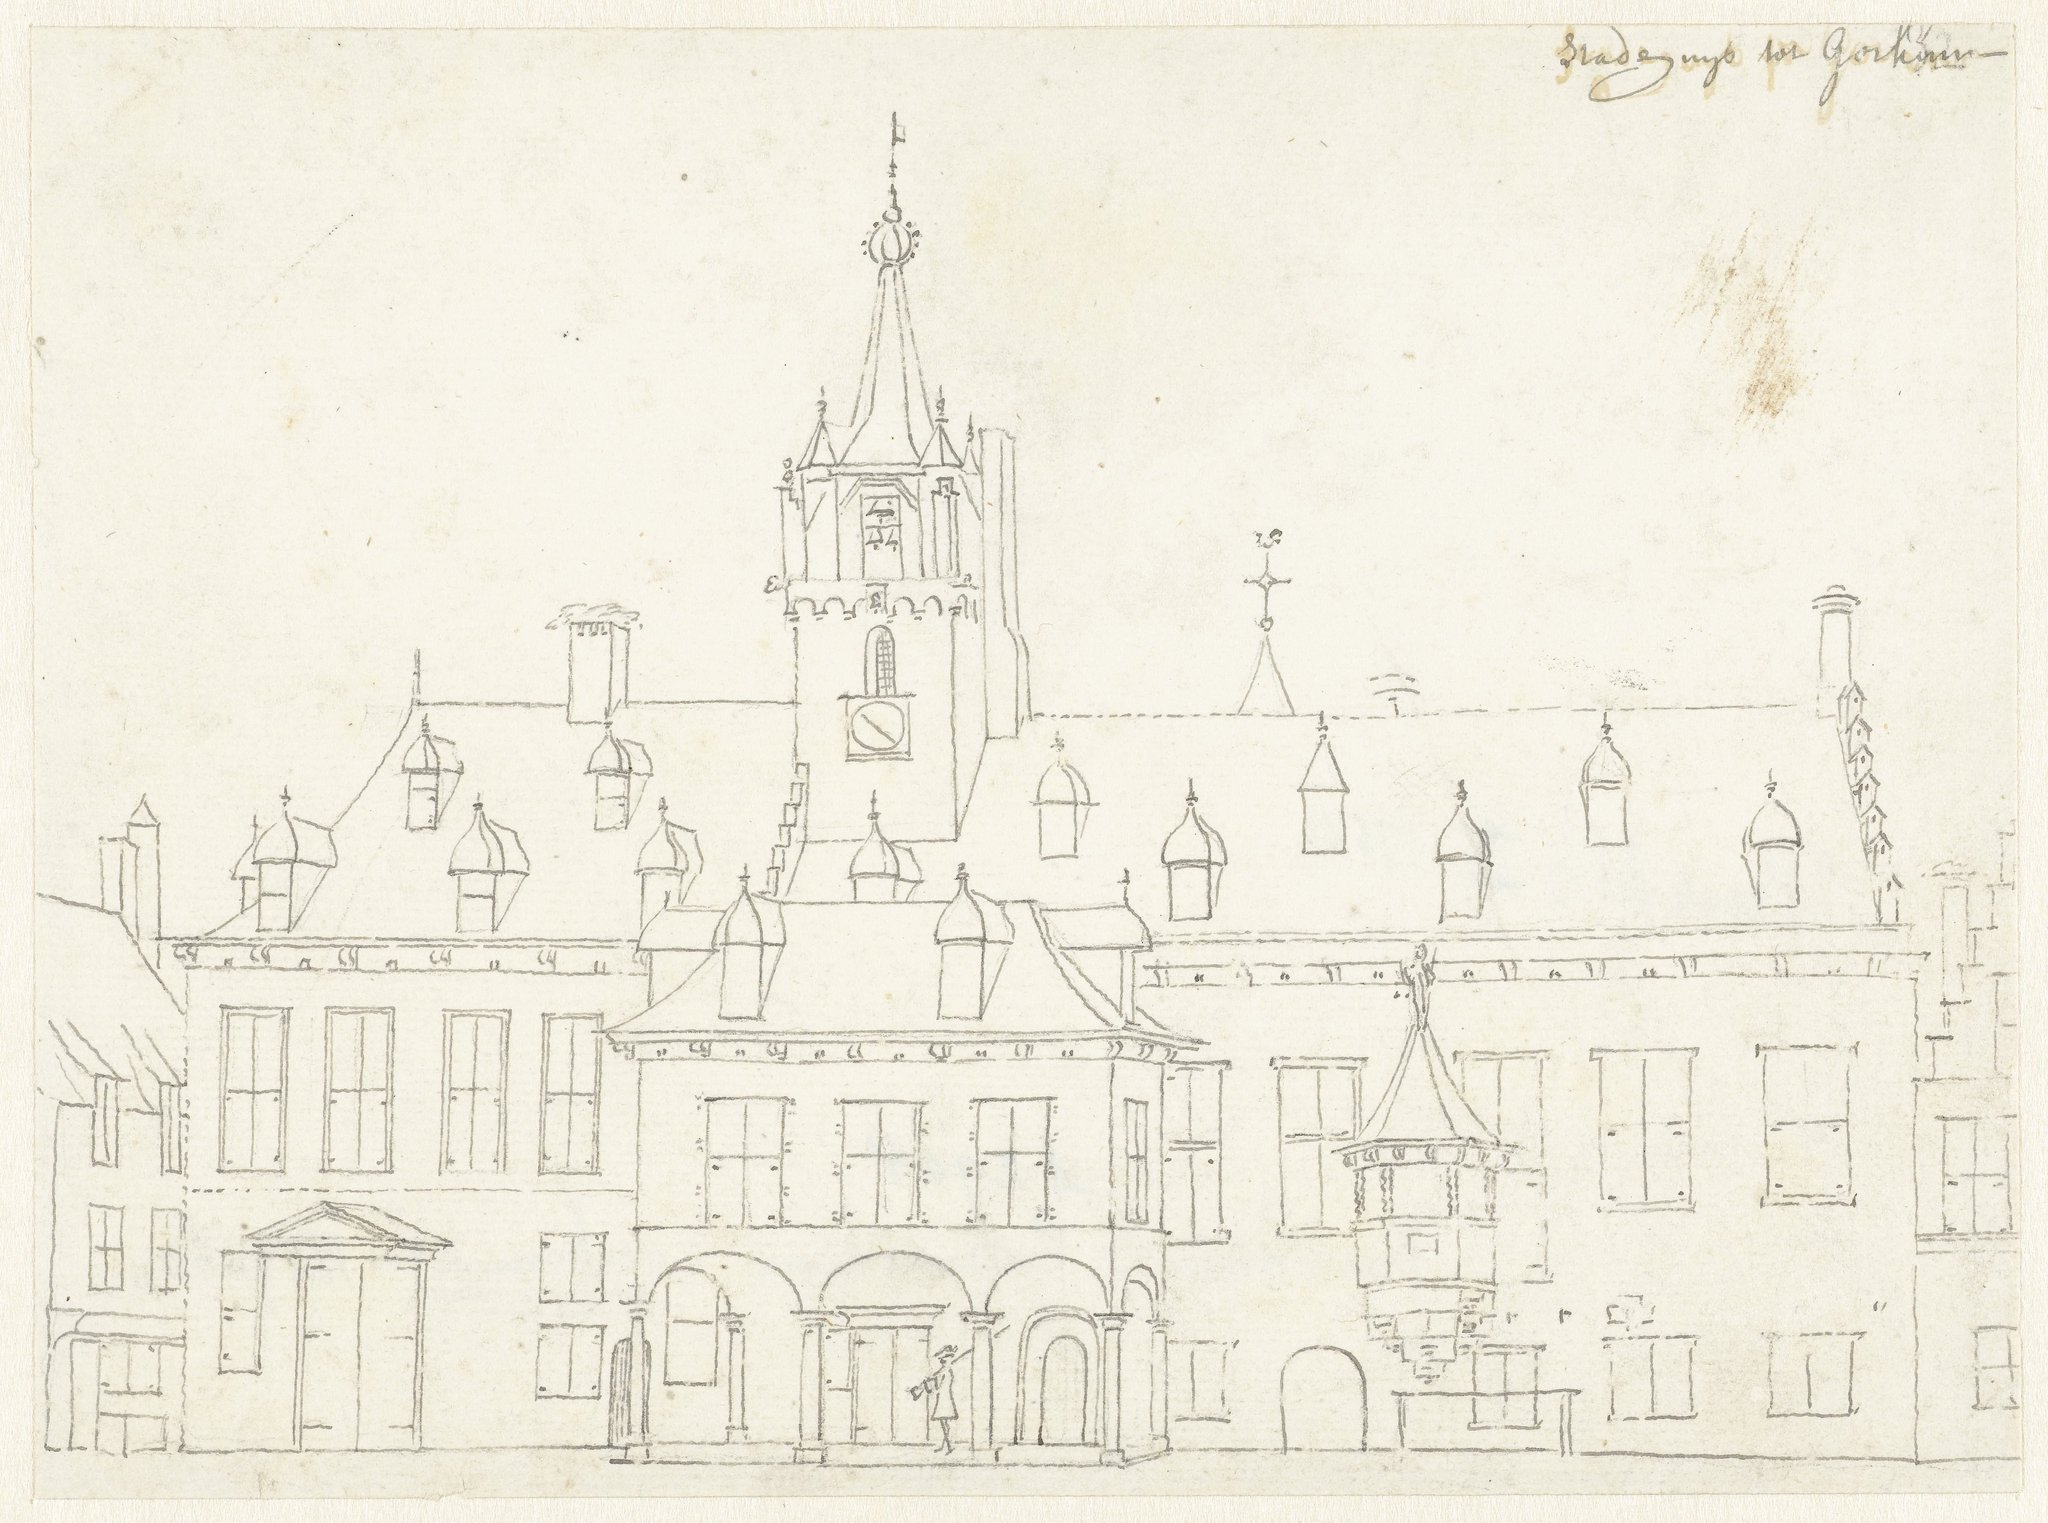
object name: drawing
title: stadhuys tot Gorkum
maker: cornelis pronk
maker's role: draughtsman, painter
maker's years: 1691-1759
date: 1701-1759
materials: ink, paper, pencil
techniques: pen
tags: townhall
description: Zie ook RP-T-1892-A-2501. Voor prent gebaseerd op deze tekening zie RP-P-AO-14-18A-6.